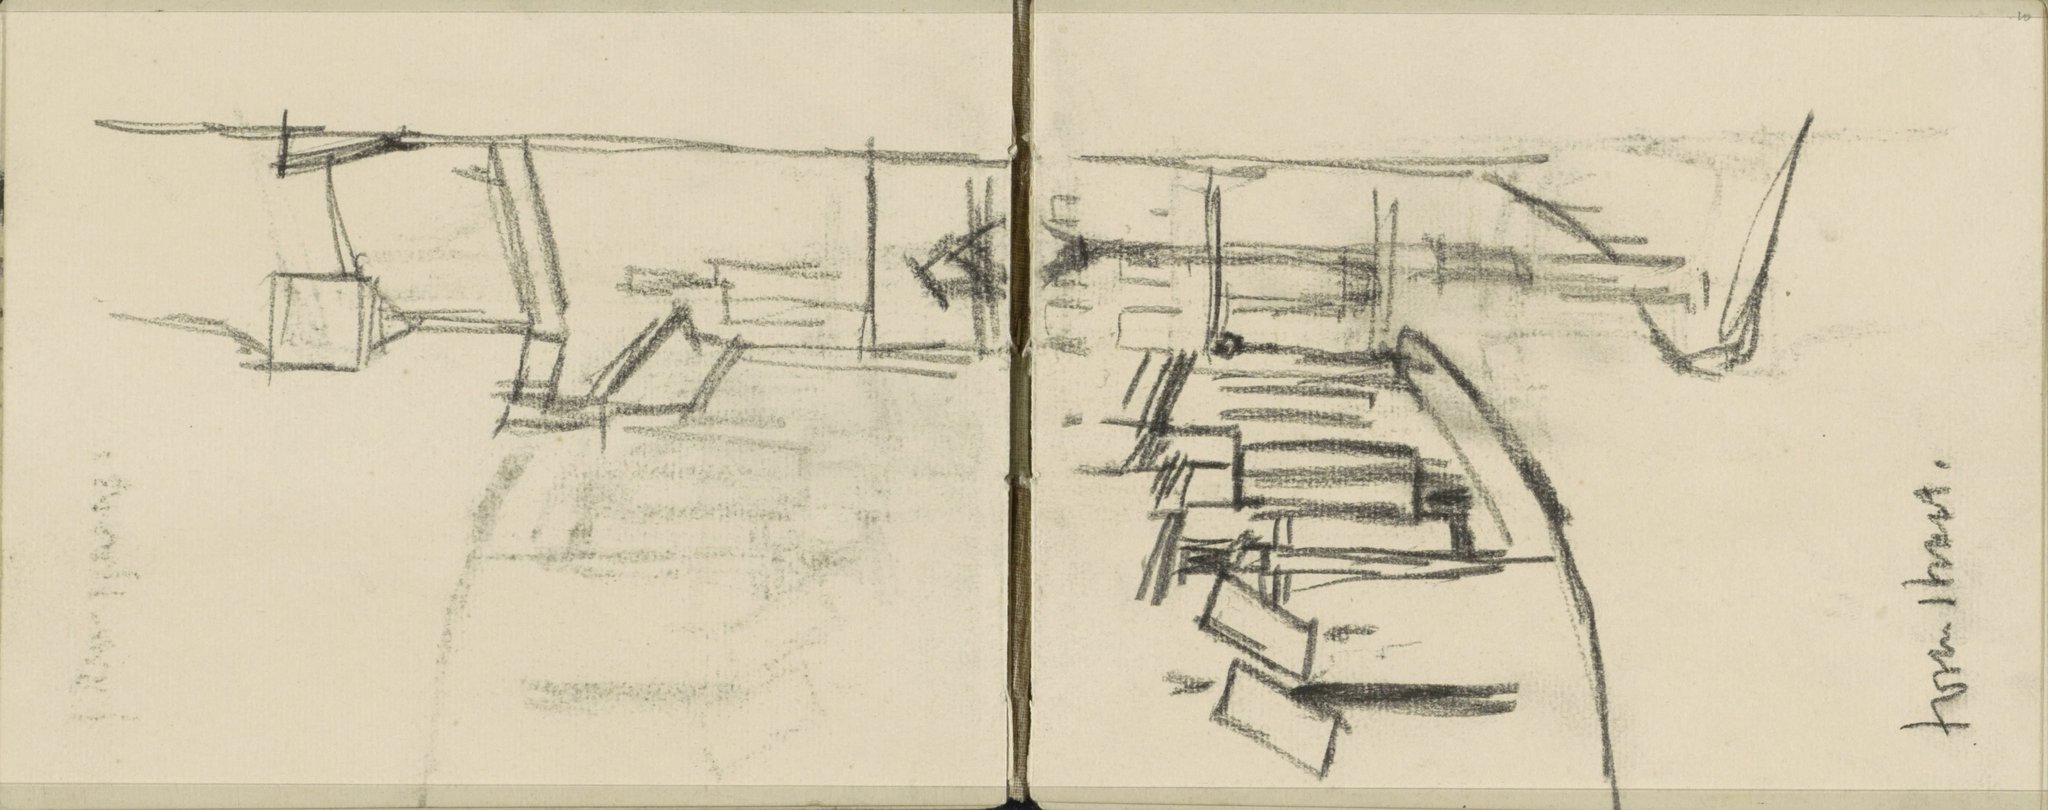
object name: sketchbook leaf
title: Gezicht op de Torensteeg te Amsterdam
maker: george hendrik breitner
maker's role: draughtsman, painter, print maker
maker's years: 1857-1923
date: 1893-1912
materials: chalk, paper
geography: amsterdam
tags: lane, alley, civic architecture; edifices; dwellings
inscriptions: annotation: ‘torenstraat.’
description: Pagina 9 en pagina 10 uit een schetsboek met 32 bladen.